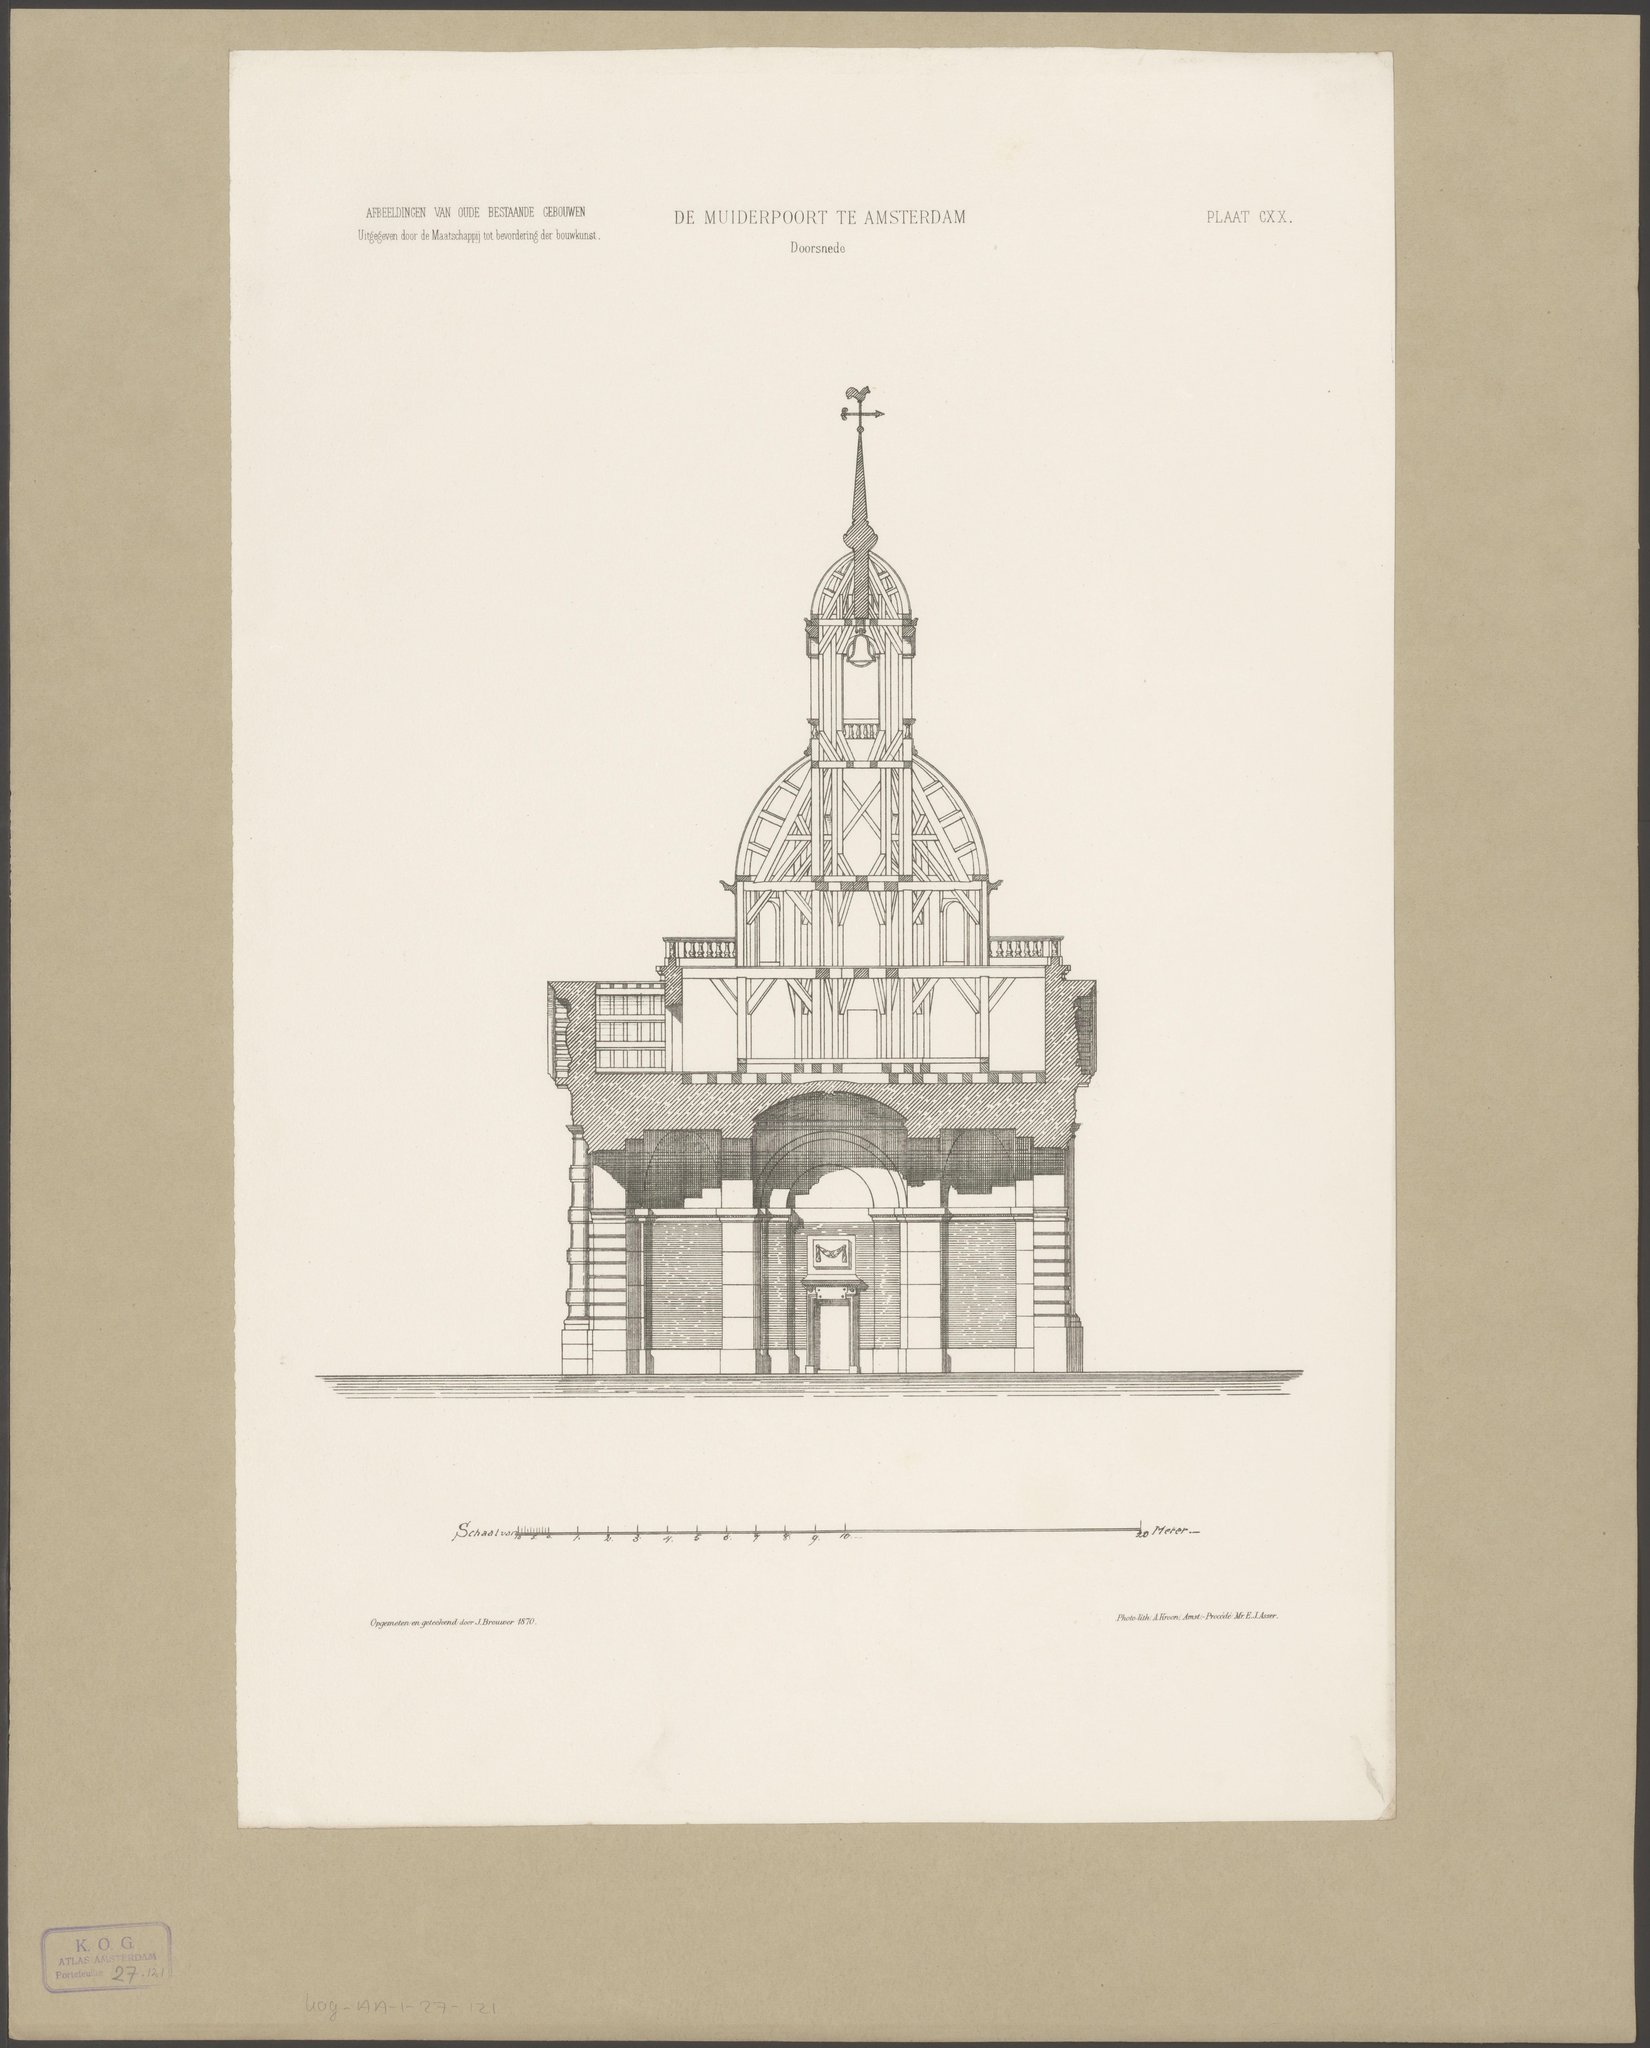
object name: photomechanical print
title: Afbeeldingen van oude bestaande gebouwen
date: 1870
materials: paper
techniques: photolithograph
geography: amsterdam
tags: city-gate, amsterdam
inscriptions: collector's mark: Lugt 1641b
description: Rechtsboven genummerd: CXX. Onderaan een schaalroede. Onderwerpsrubriek binnen de Atlas Amsterdam: Poorten, verzamelbladen, J. Tweede Muiderpoort.